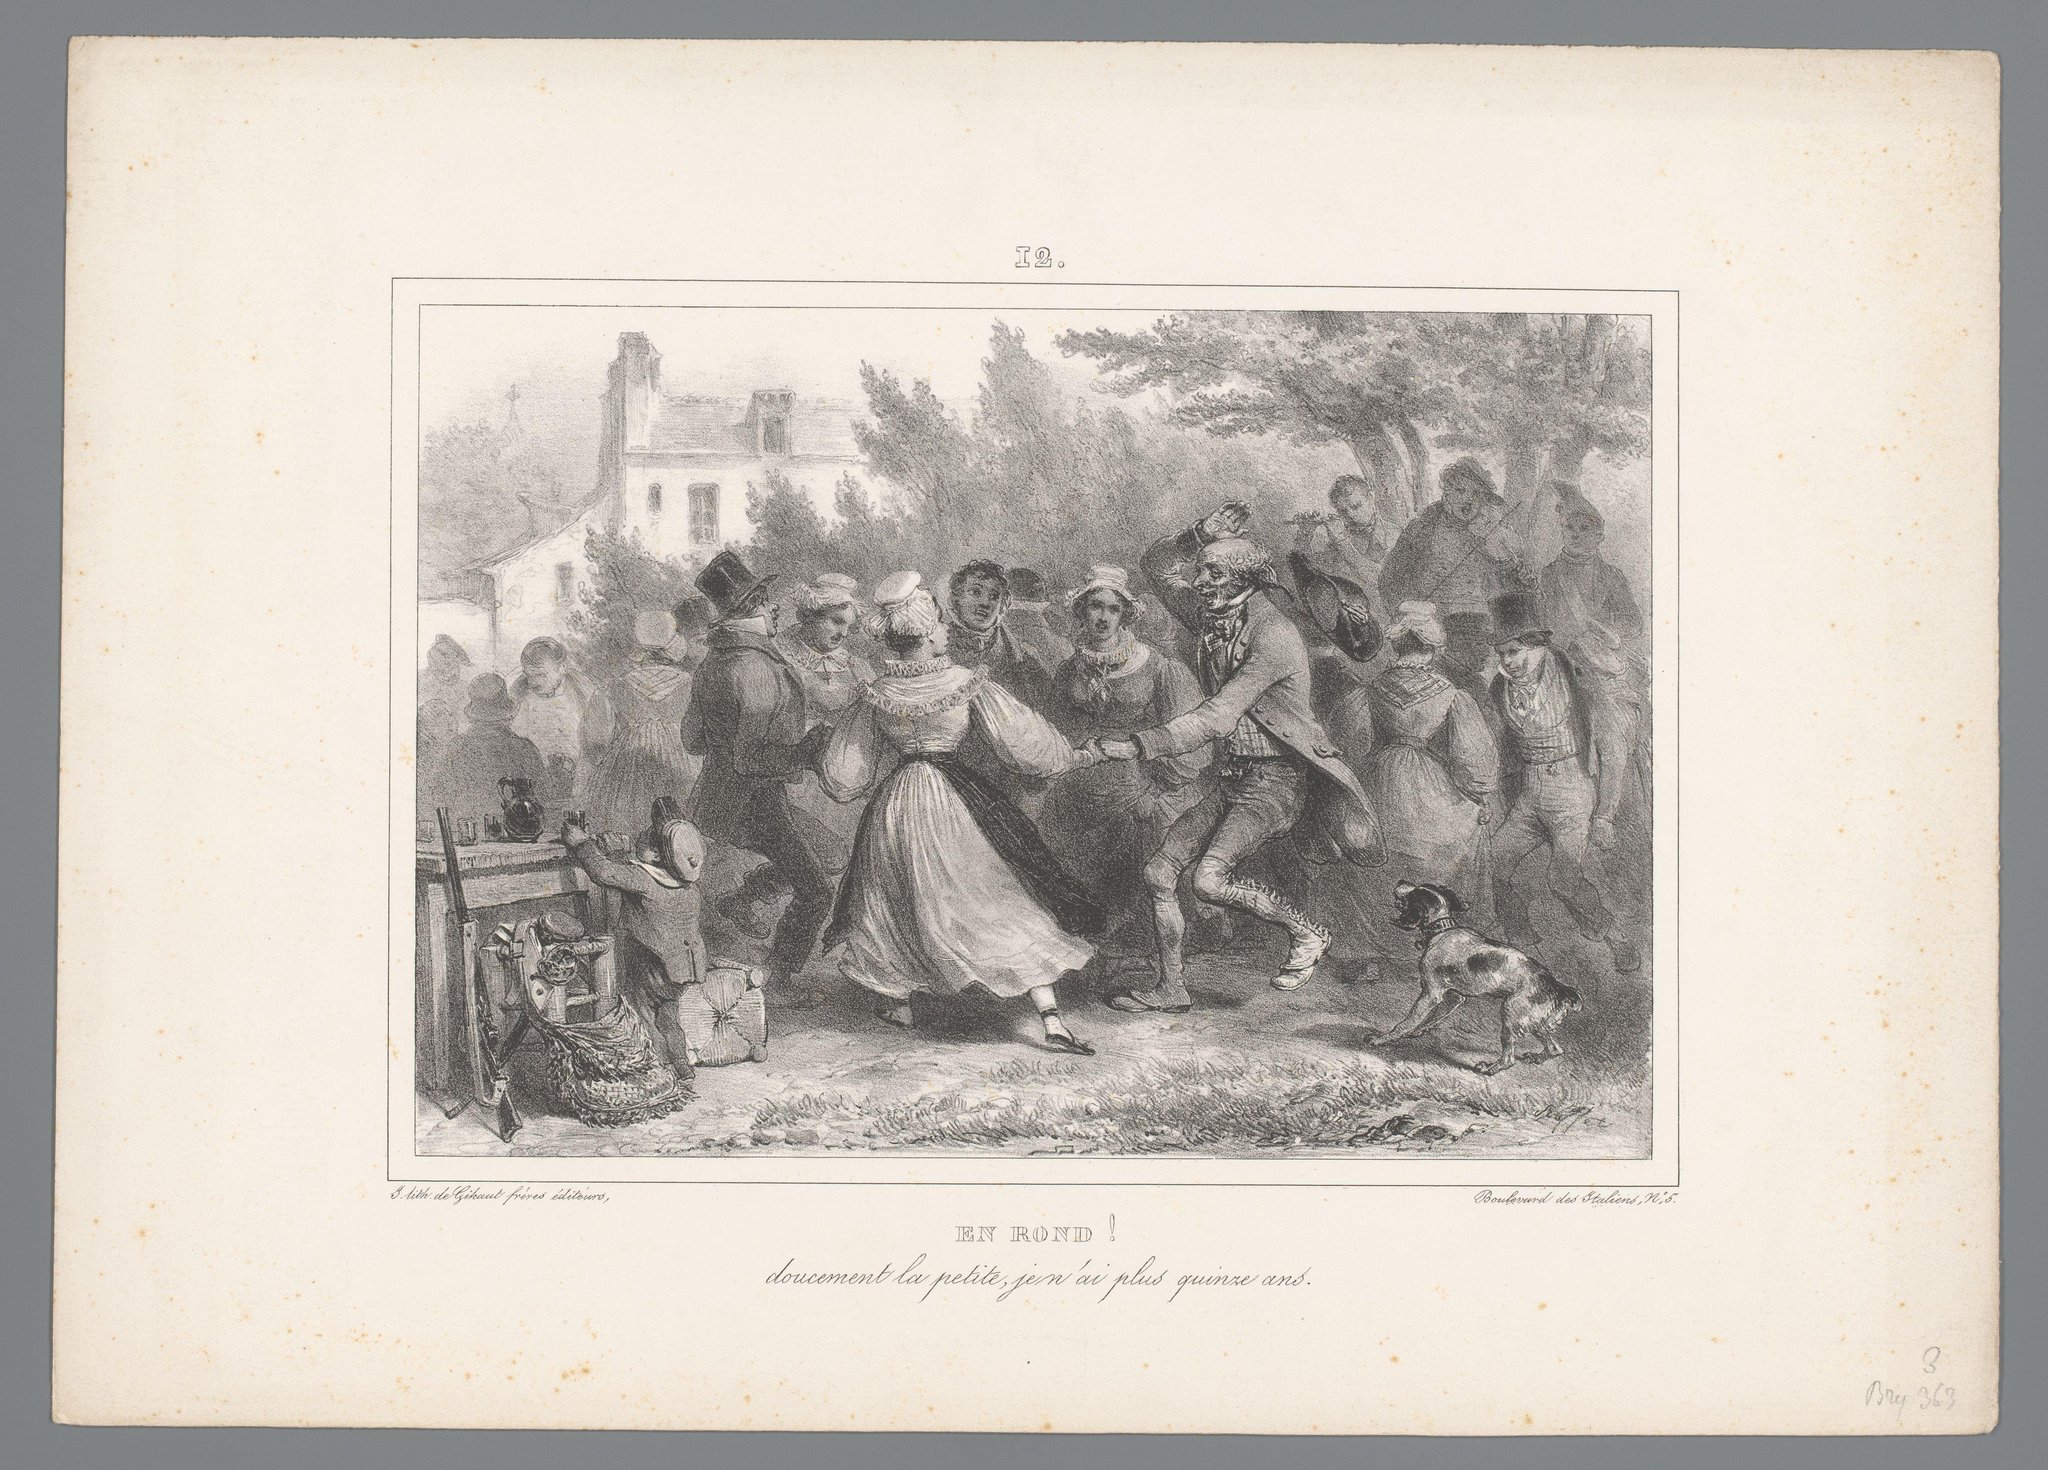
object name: print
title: Muziek en dansende mensen waaronder een jonge vrouw met oude man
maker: denis auguste marie raffet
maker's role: draughtsman, print maker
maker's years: 1804-1860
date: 1832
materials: paper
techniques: lithograph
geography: paris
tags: small group of musicians, chamber orchestra, jazz band, more than one couple dancing